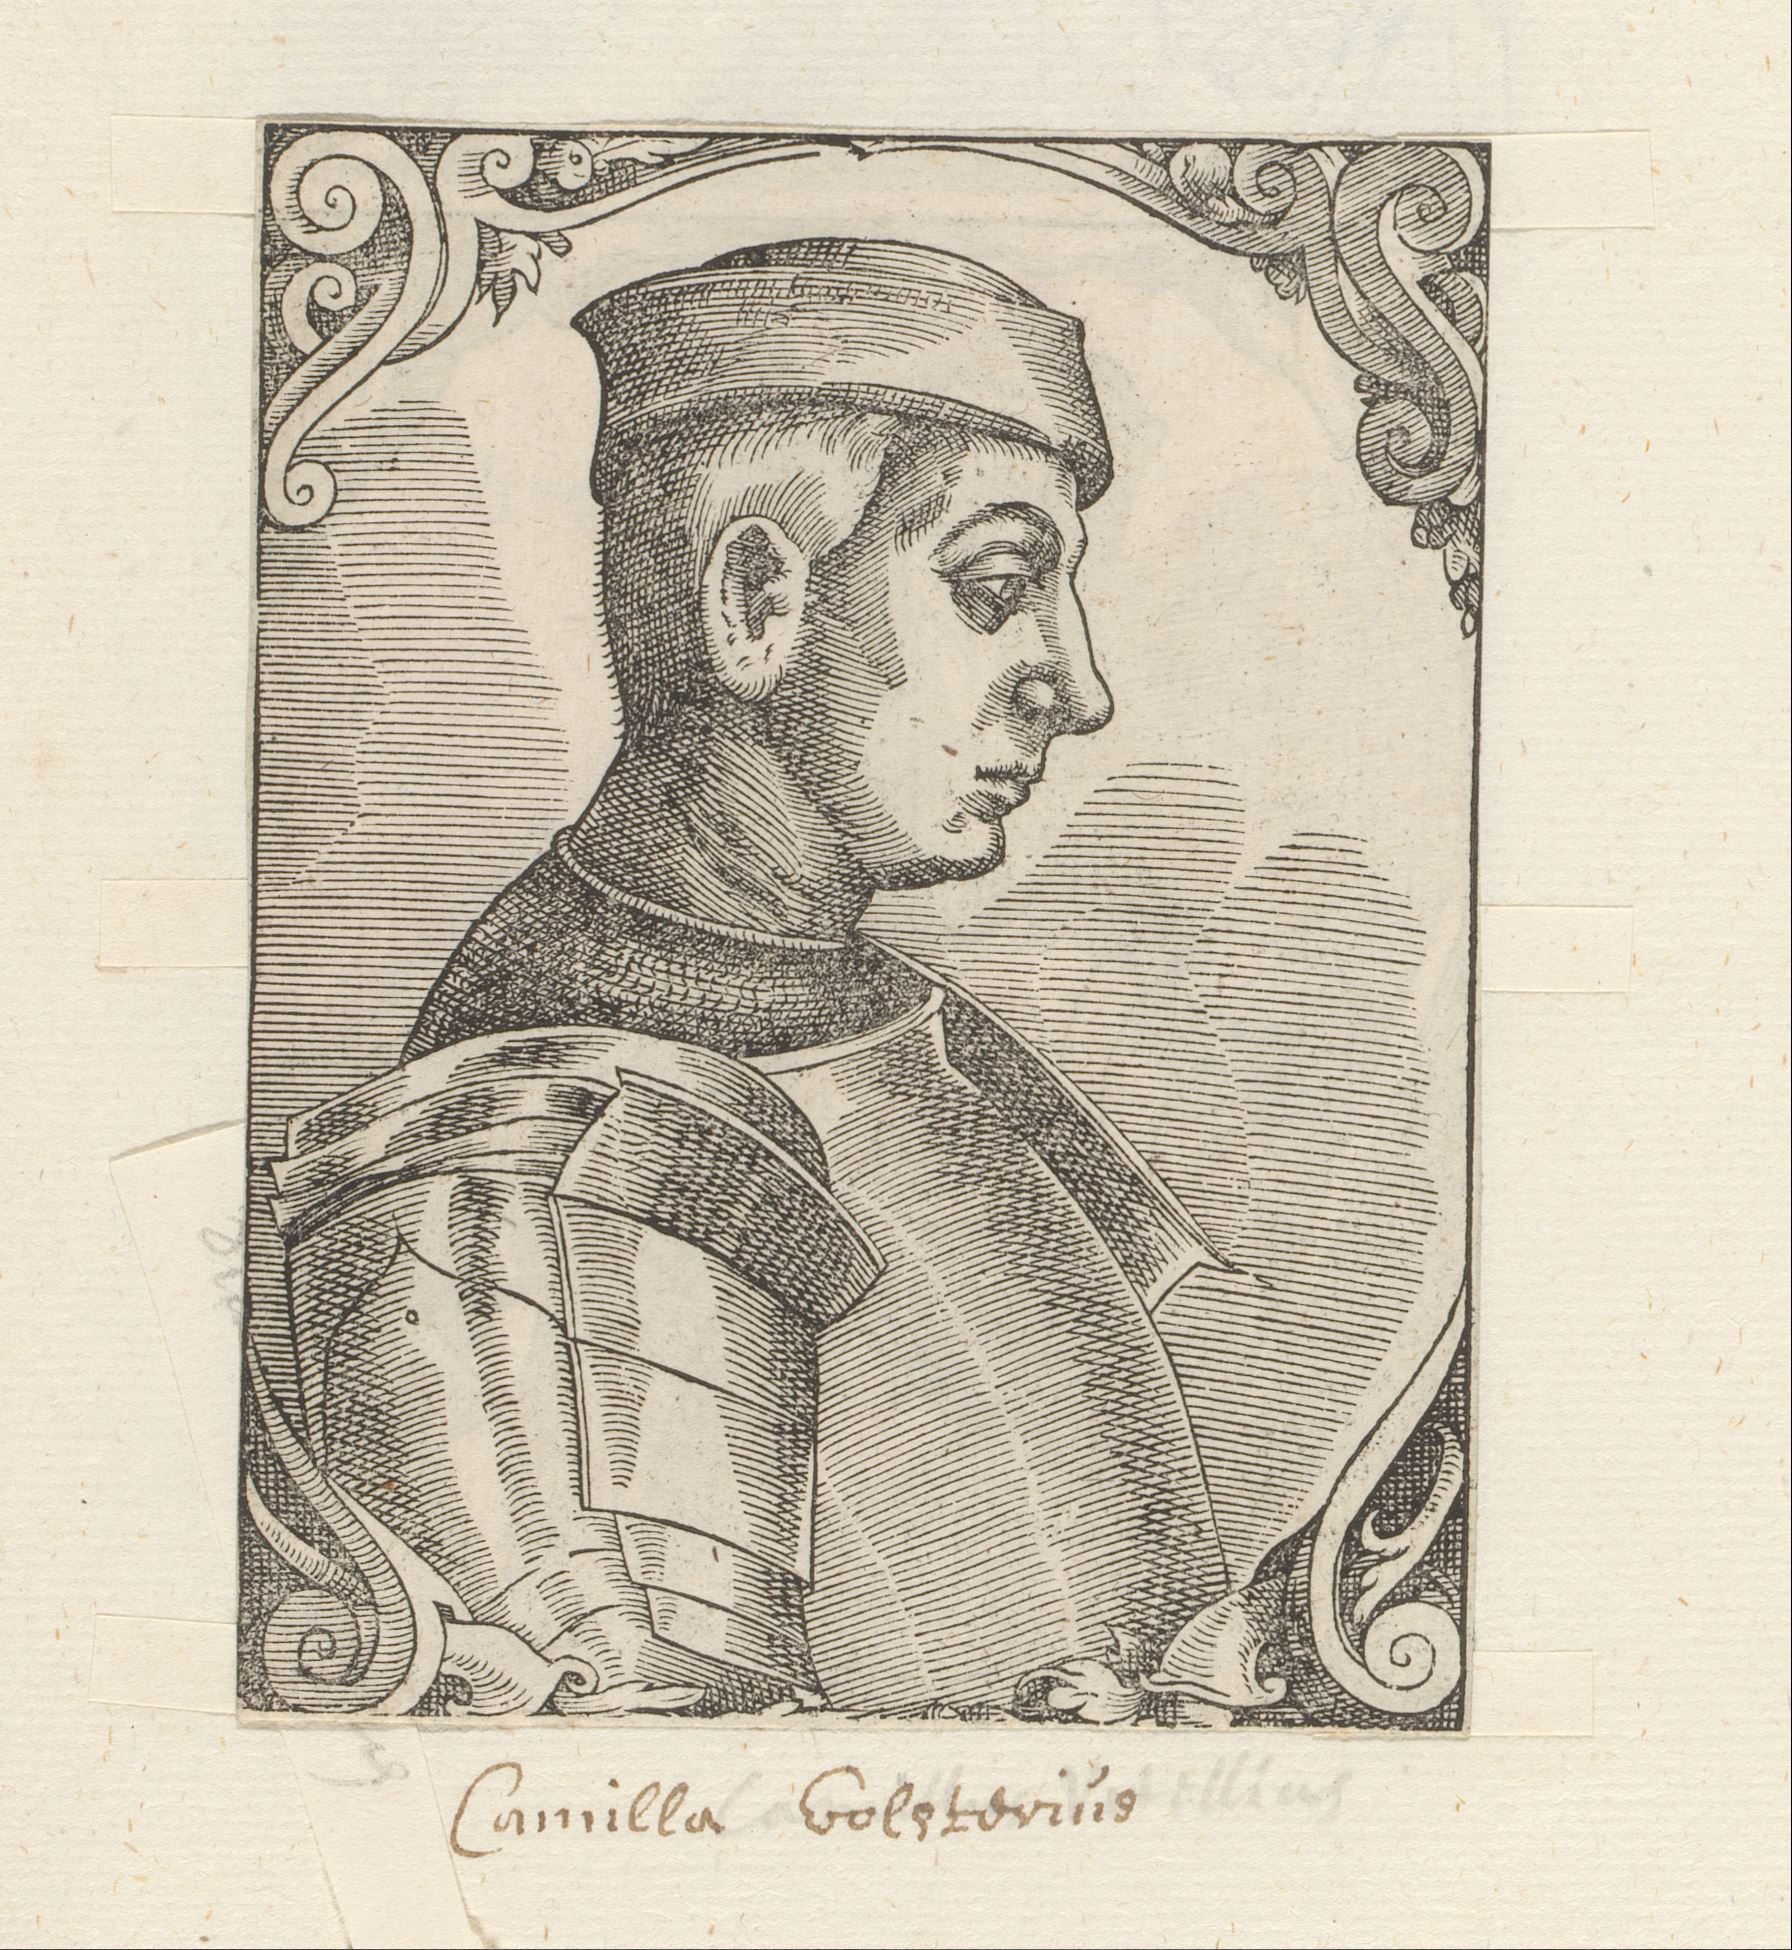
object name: album leaf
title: Portret van Camillus Vitellus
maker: Anonymous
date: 1549-1575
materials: paper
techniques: woodcut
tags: historical persons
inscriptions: annotation: ‘Camilla Volstevius’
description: Prent gebruikt in: Giovio, Paolo. Elogia Virorum bellica virtute illustrium (...). Bazel: Peter Perna, 1575.